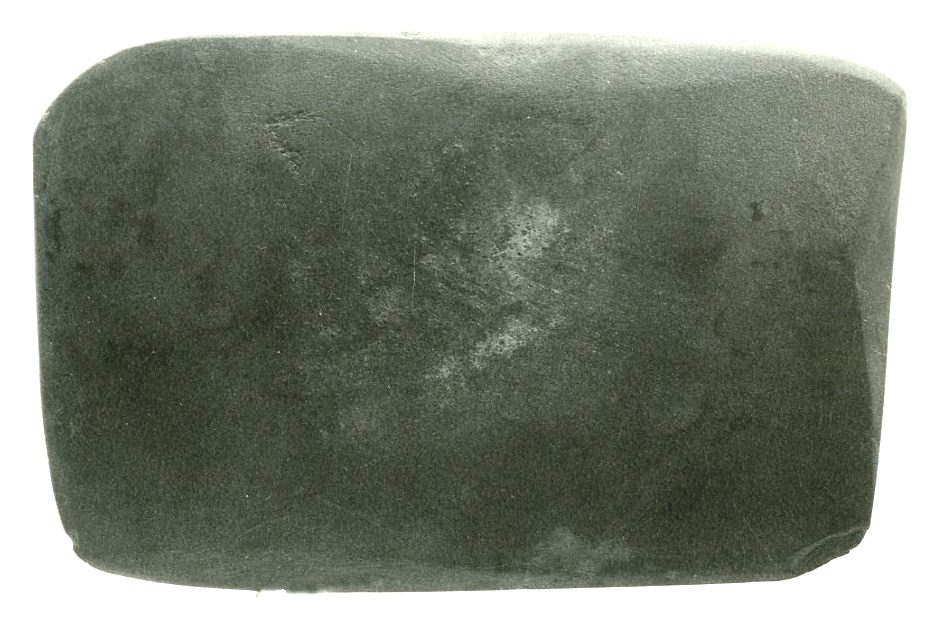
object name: palette, rectangular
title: Rectangular palette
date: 3300-3100 BCE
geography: egypt